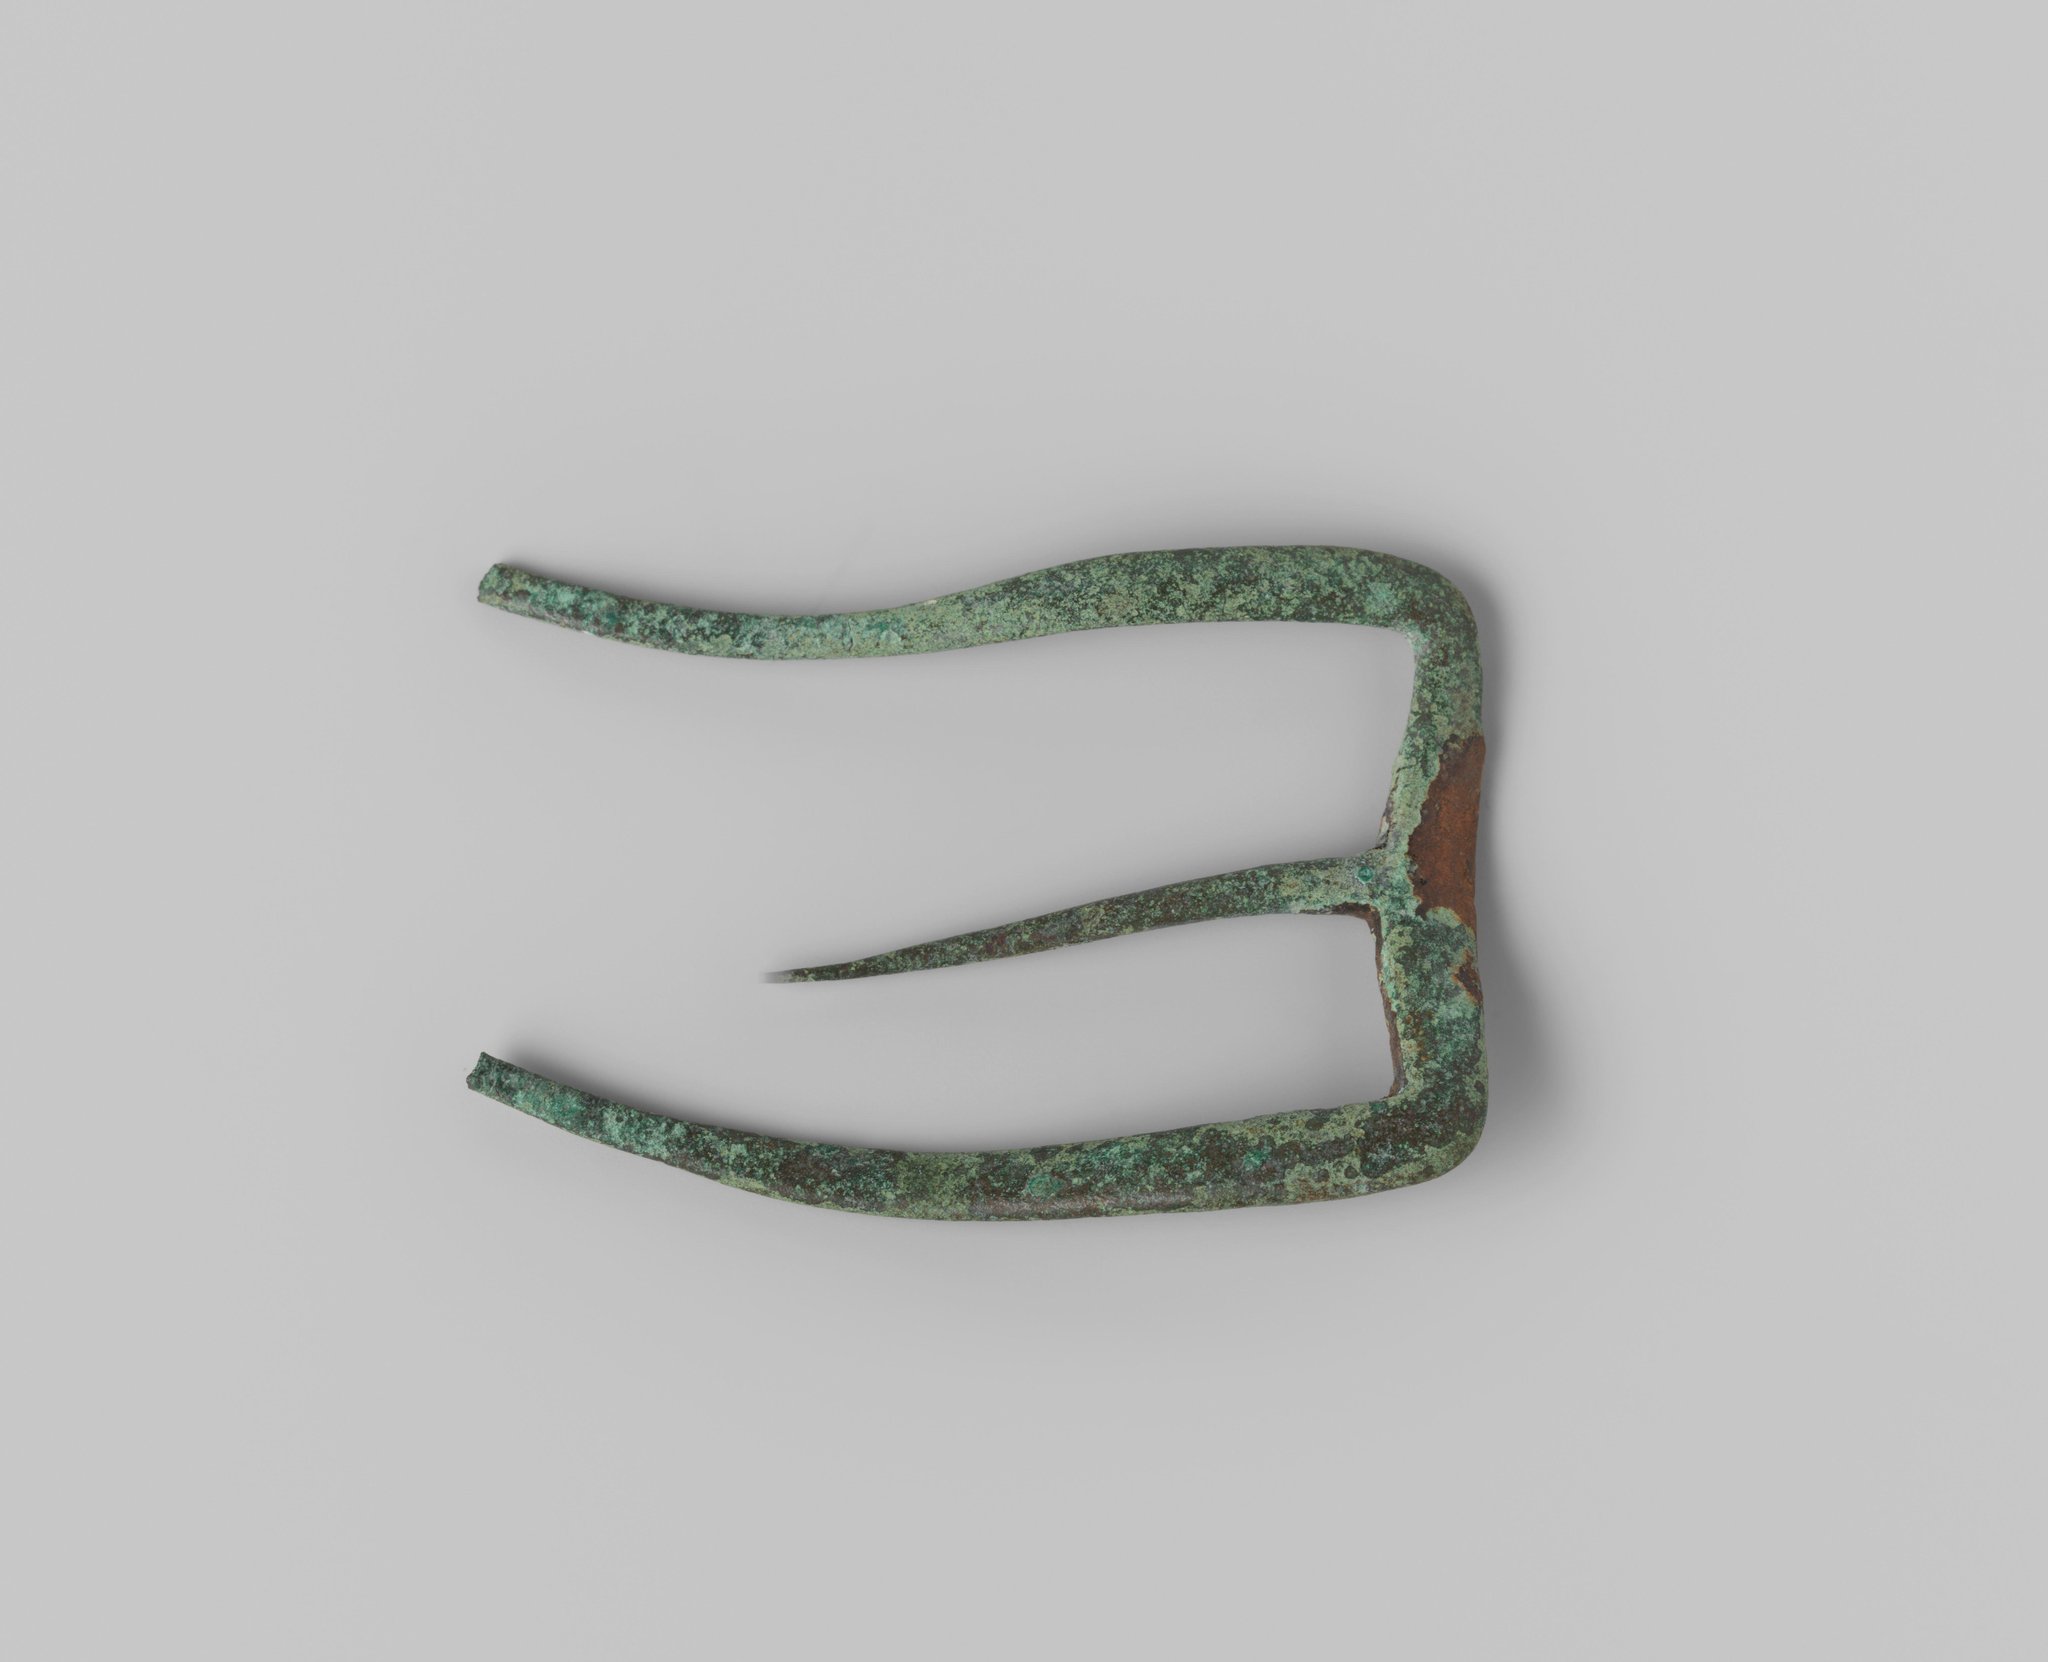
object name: belt buckle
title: Fragment riemgesp uit het wrak van de Oost-Indiëvaarder Hollandia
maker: Anonymous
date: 1700-1743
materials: copper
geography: netherlands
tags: verenigde oostindische compagnie, hollandia (schip), annet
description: Rectangular, fragm of ring with spindle, id. NG 1980-27H2852, belt buckle.